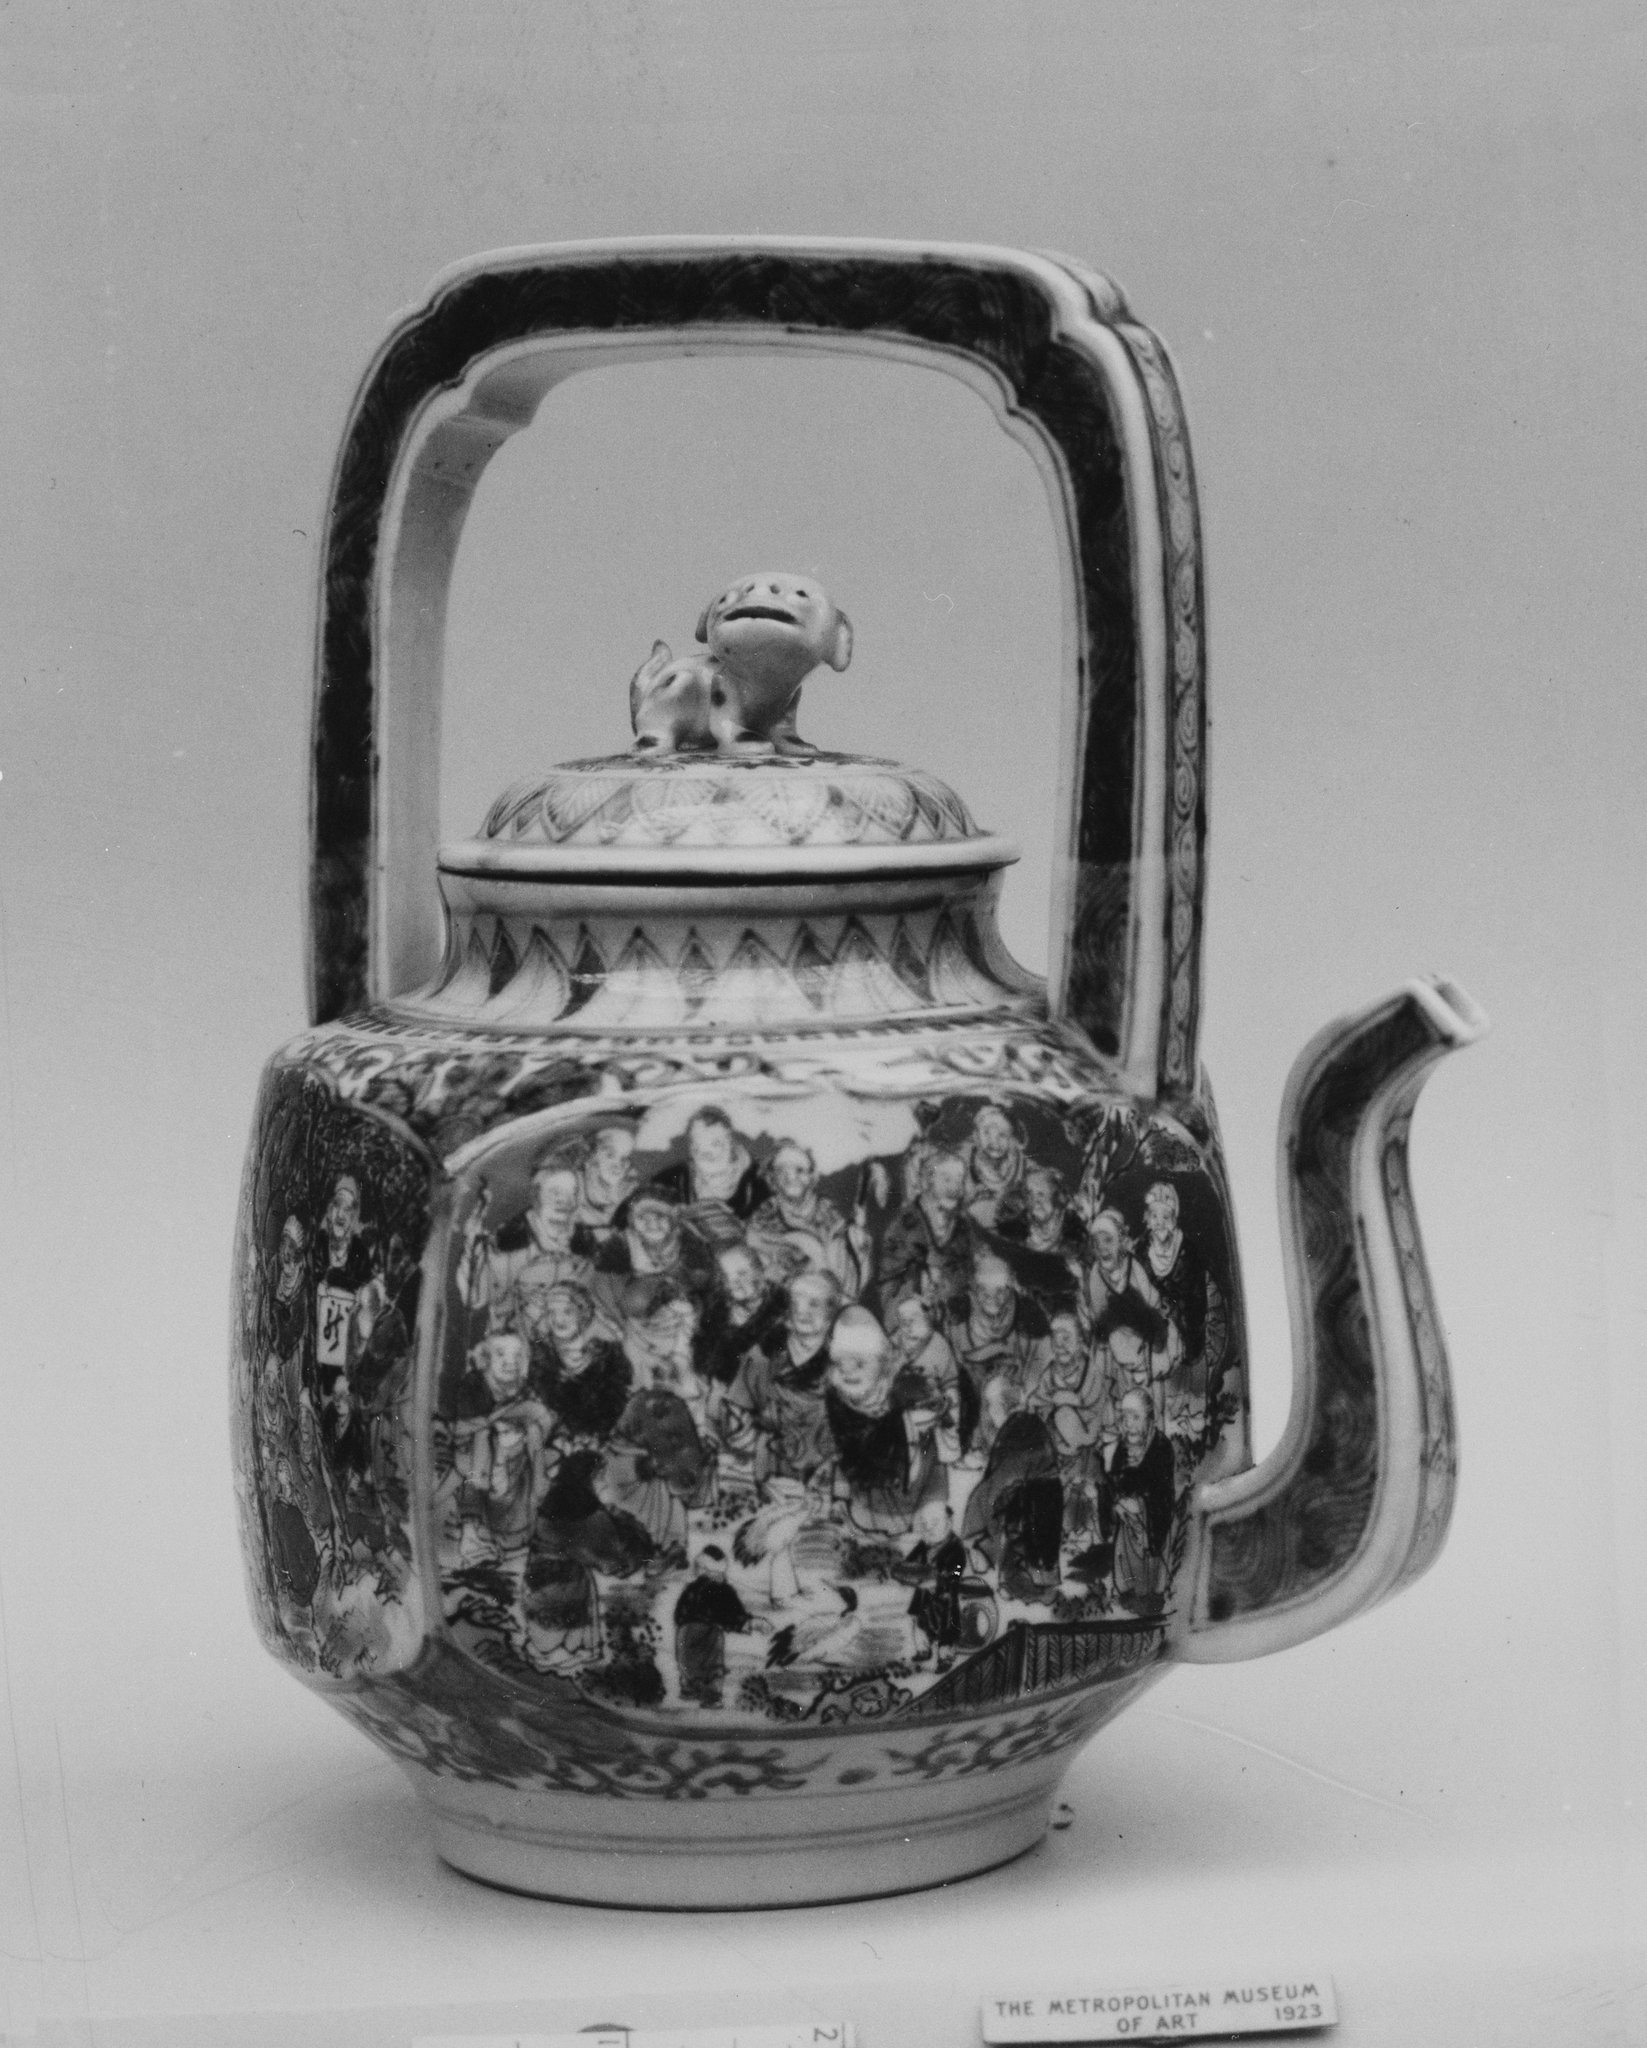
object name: wine pot with cover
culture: japanese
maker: kitei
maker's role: artist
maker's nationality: japanese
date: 1867-1900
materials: enamel, glaze, porcelain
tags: human figures,animals